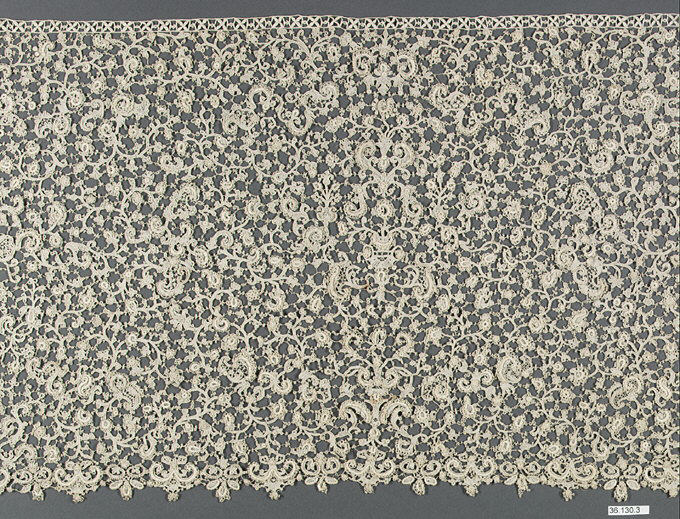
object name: flounce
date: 1601-1700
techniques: lace